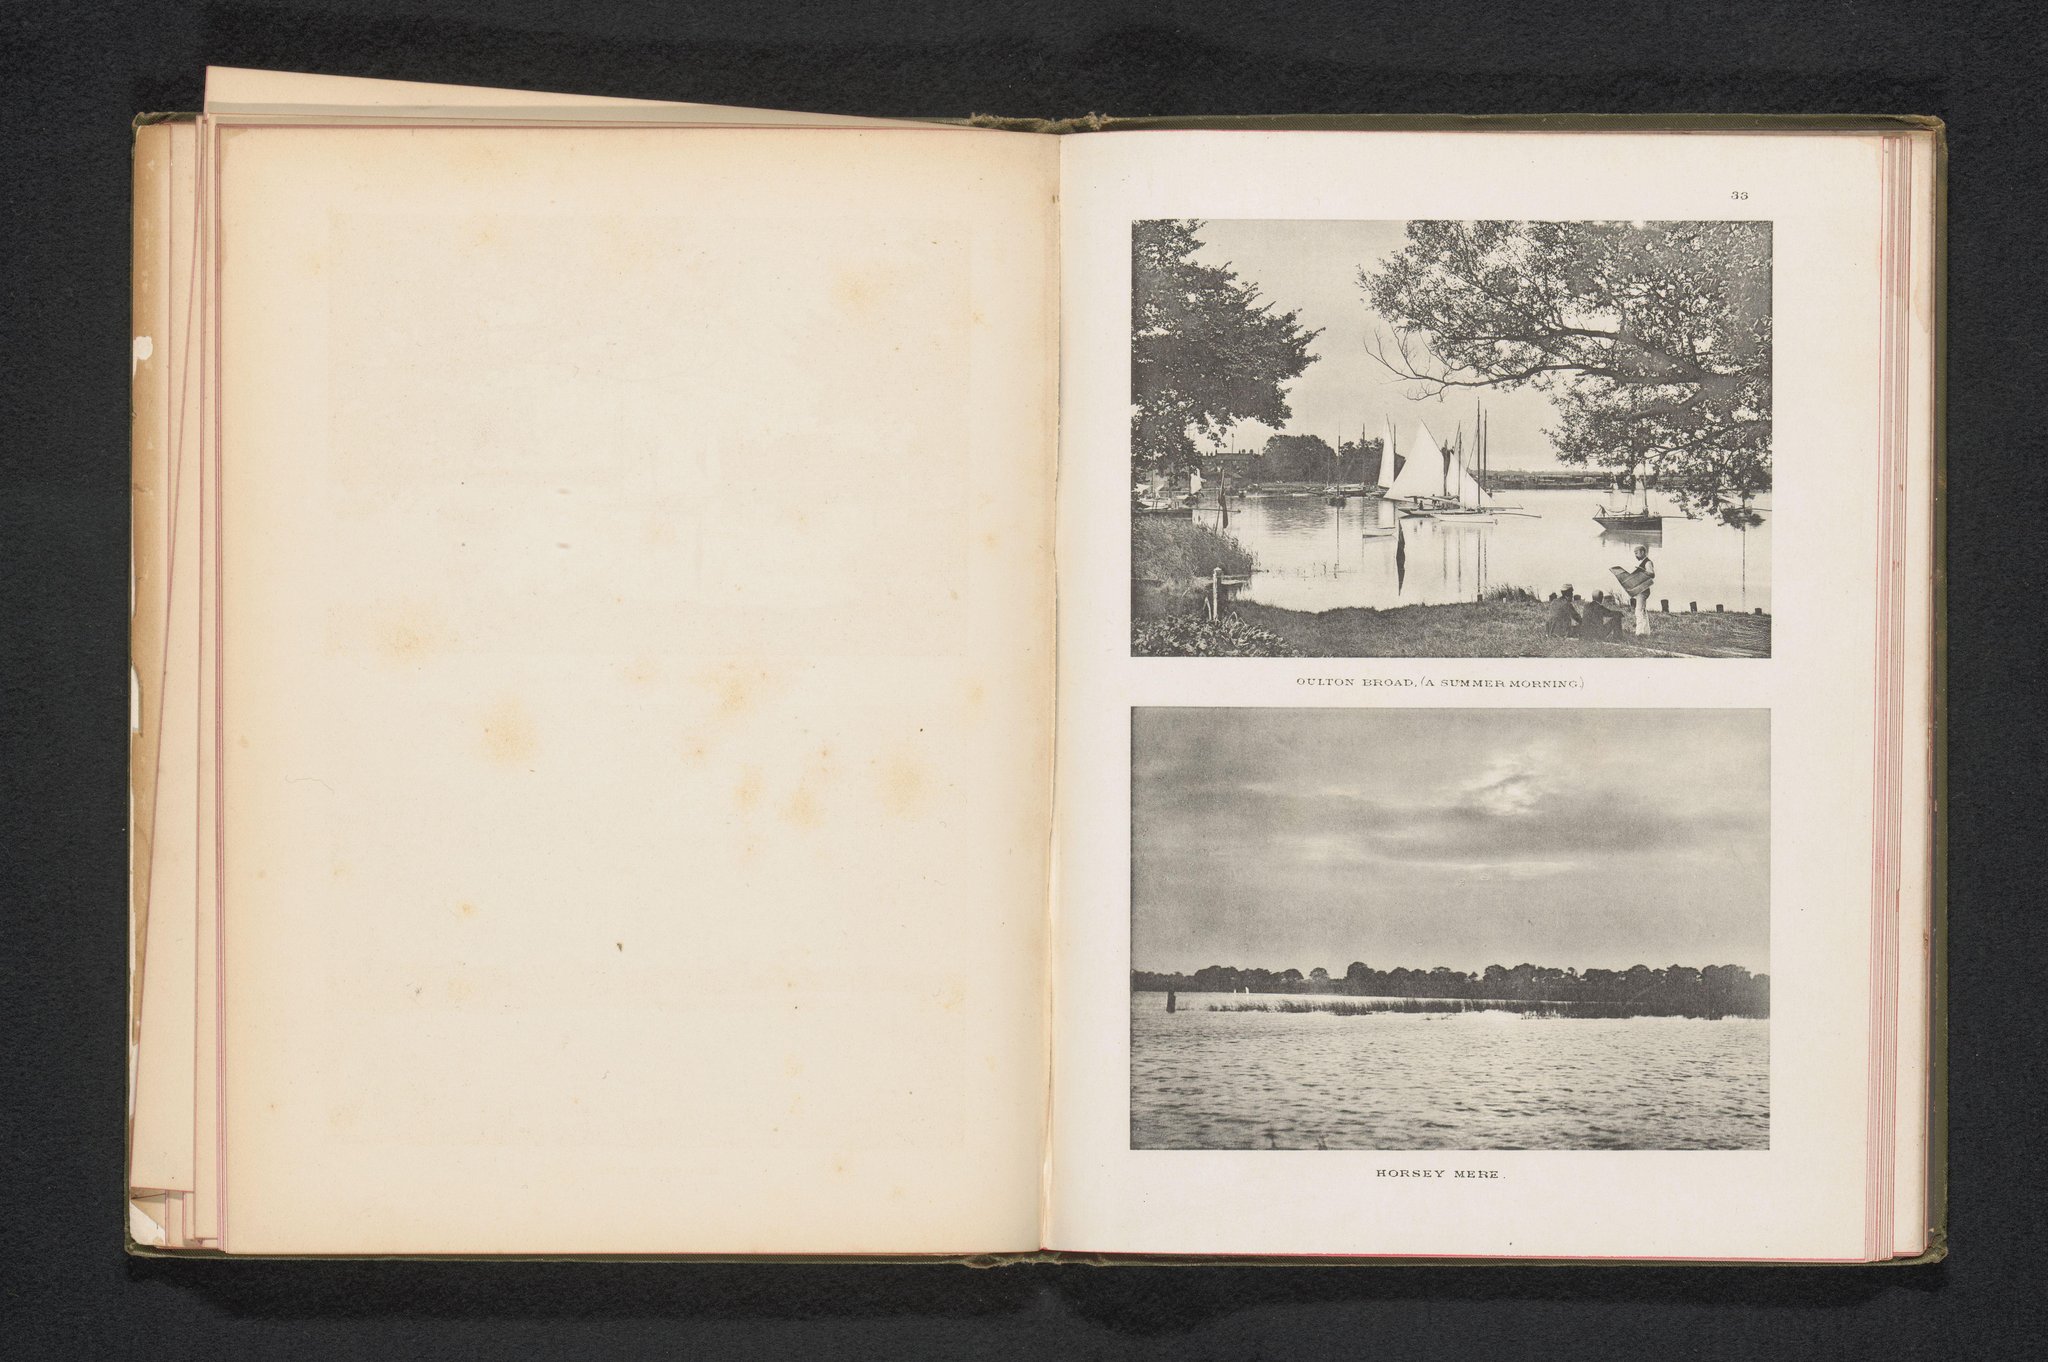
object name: photomechanical print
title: Gezicht op Horsey Mere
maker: john payne jennings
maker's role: fotograaf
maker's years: 1843-1926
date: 1886-1891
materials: paper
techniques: photograph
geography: surrey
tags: landscapes with waters, waterscapes, seascapes (in the temperate zone), lake